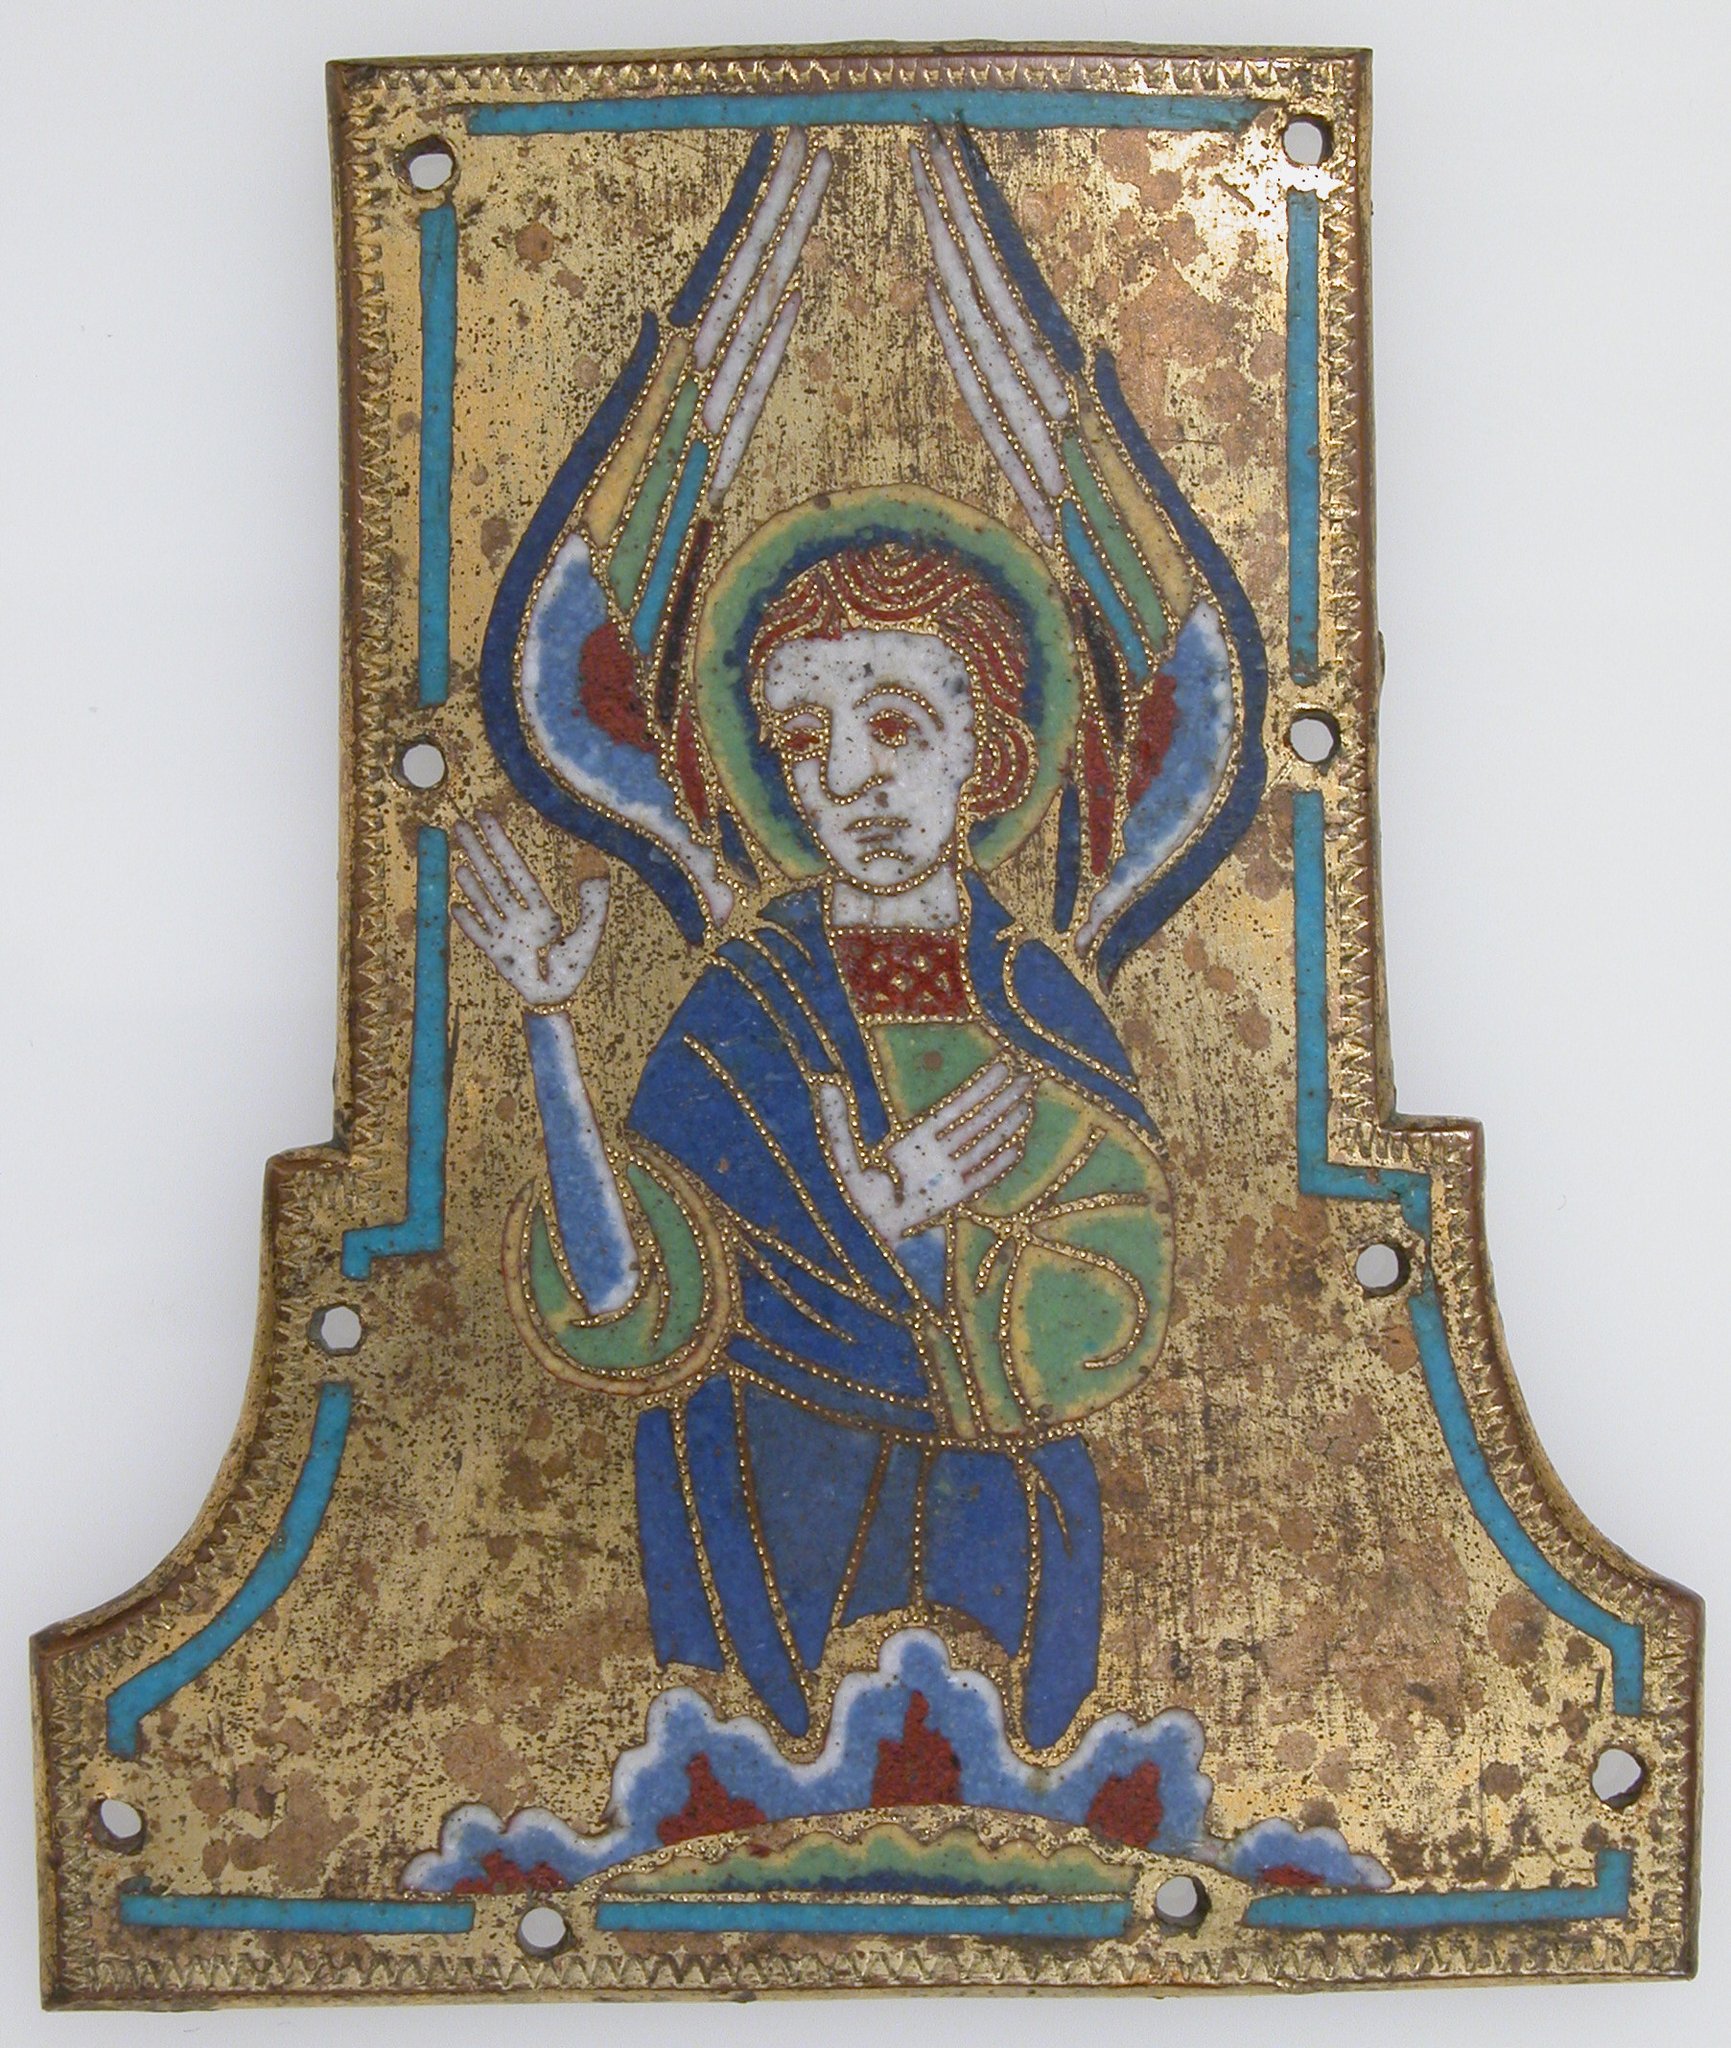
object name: cross terminal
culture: french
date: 1101-1200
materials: gilt copper, enamel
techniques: enamel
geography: france